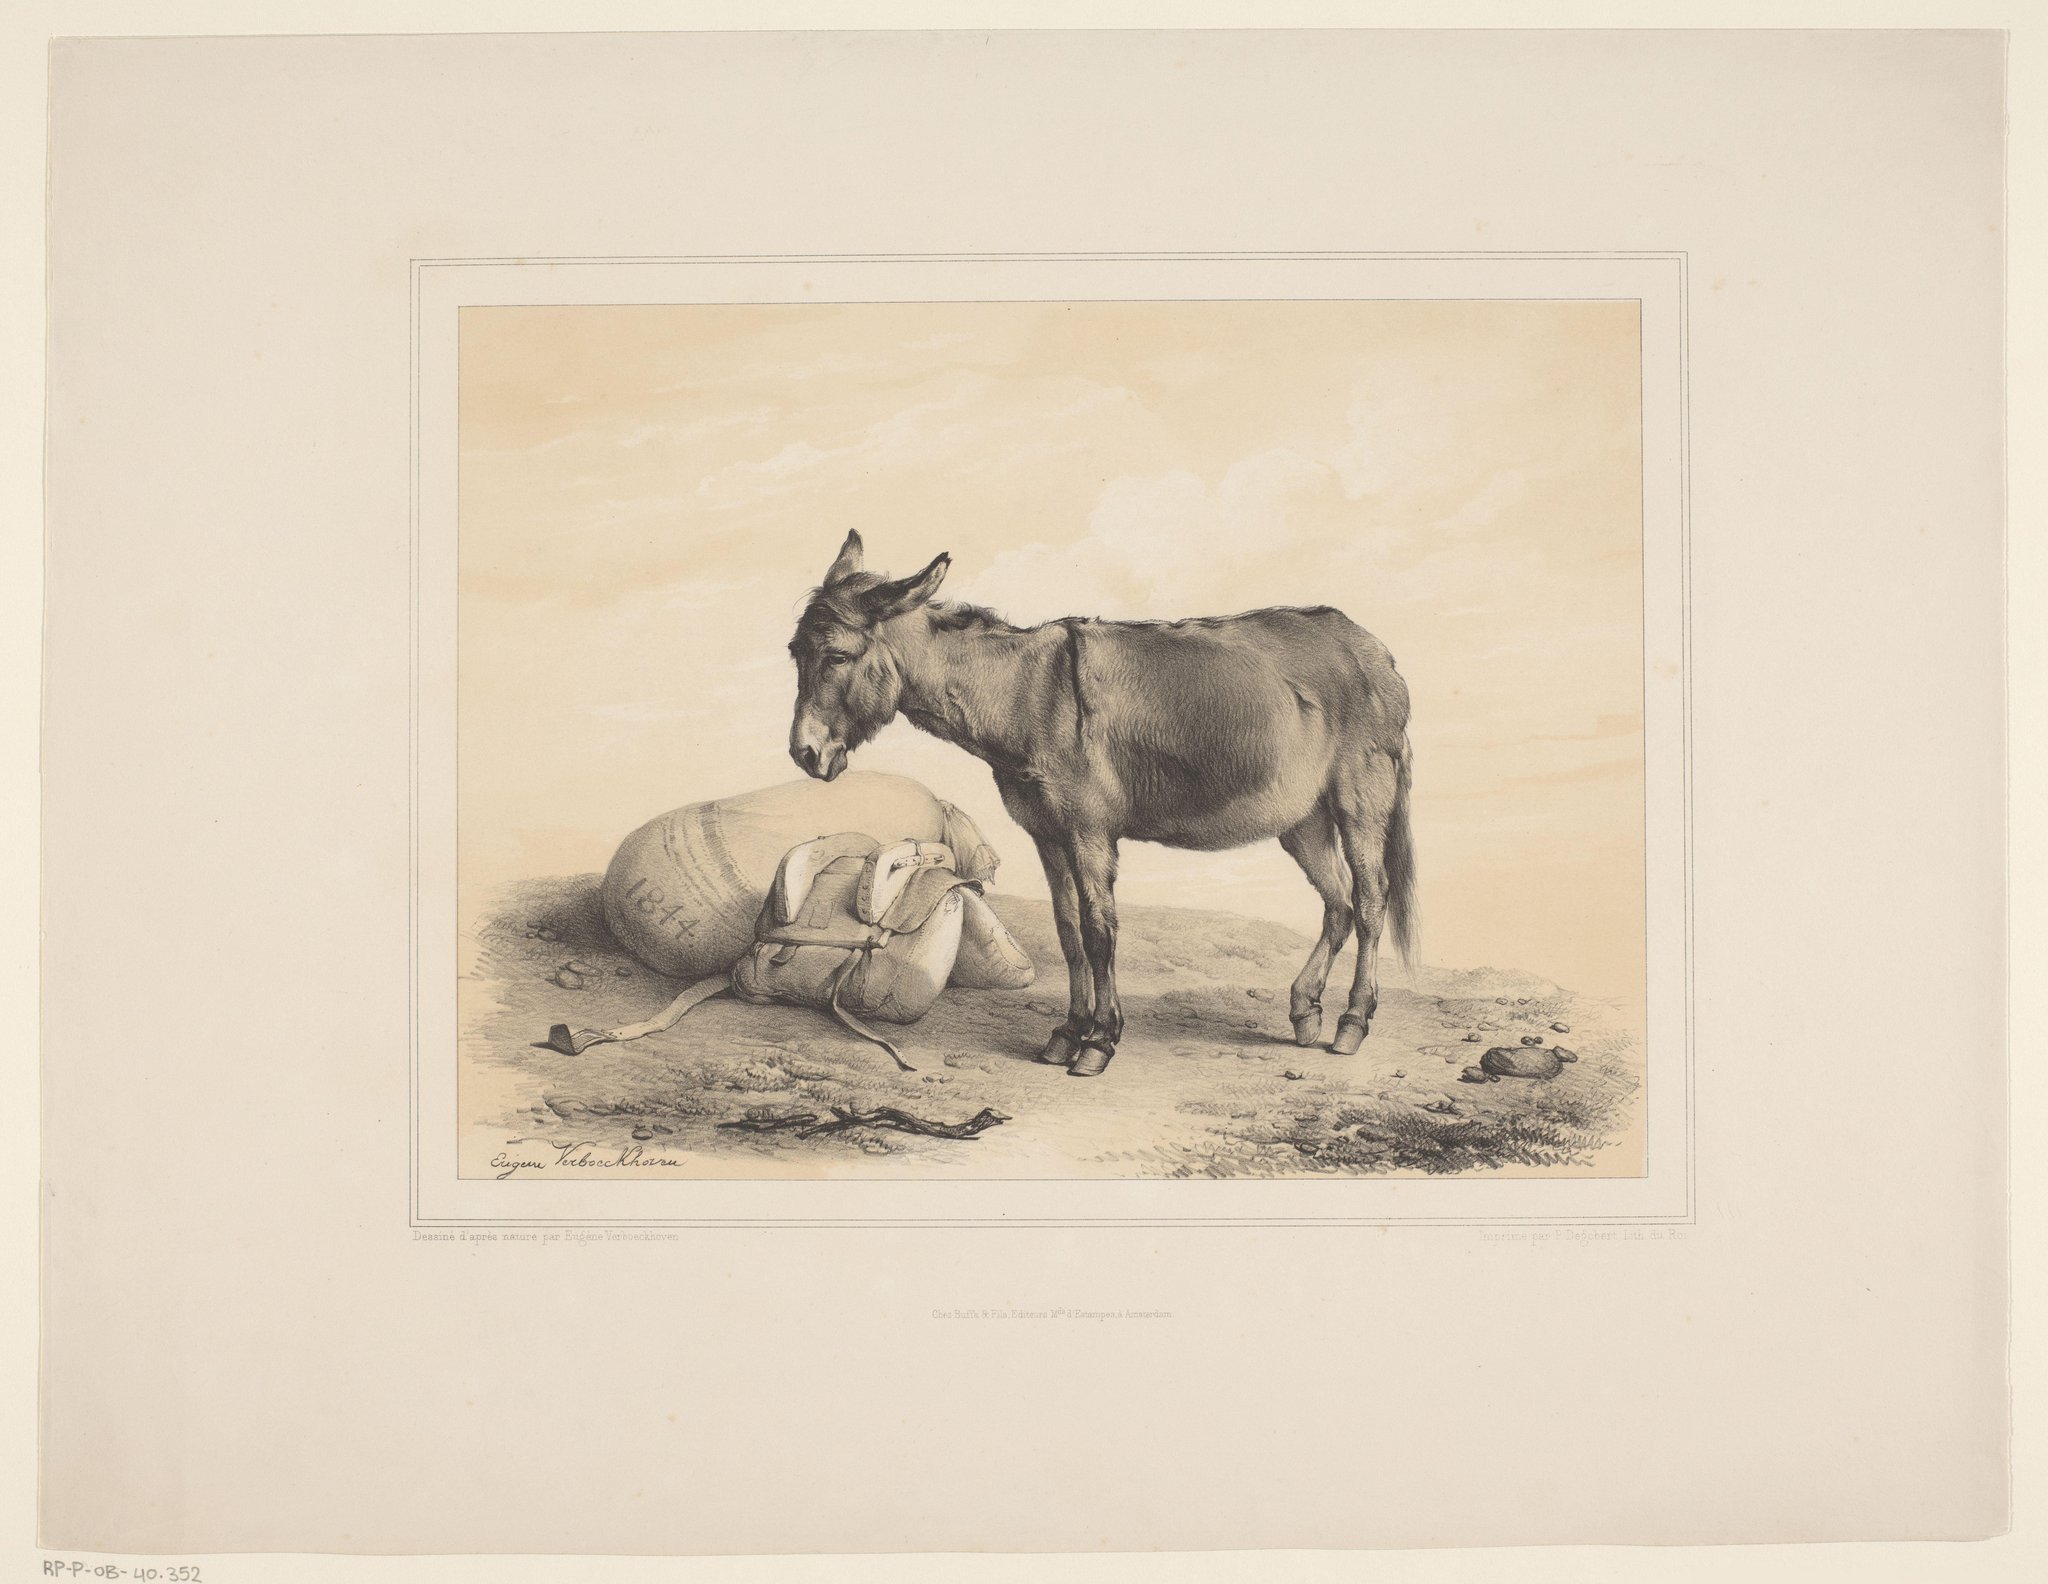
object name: print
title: Diverse dieren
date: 1844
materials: paper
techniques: tone lithography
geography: amsterdam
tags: pack-animal, ass, donkey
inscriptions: collector's mark: Lugt 2228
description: Prent maakt deel uit van een serie van dertien prenten.